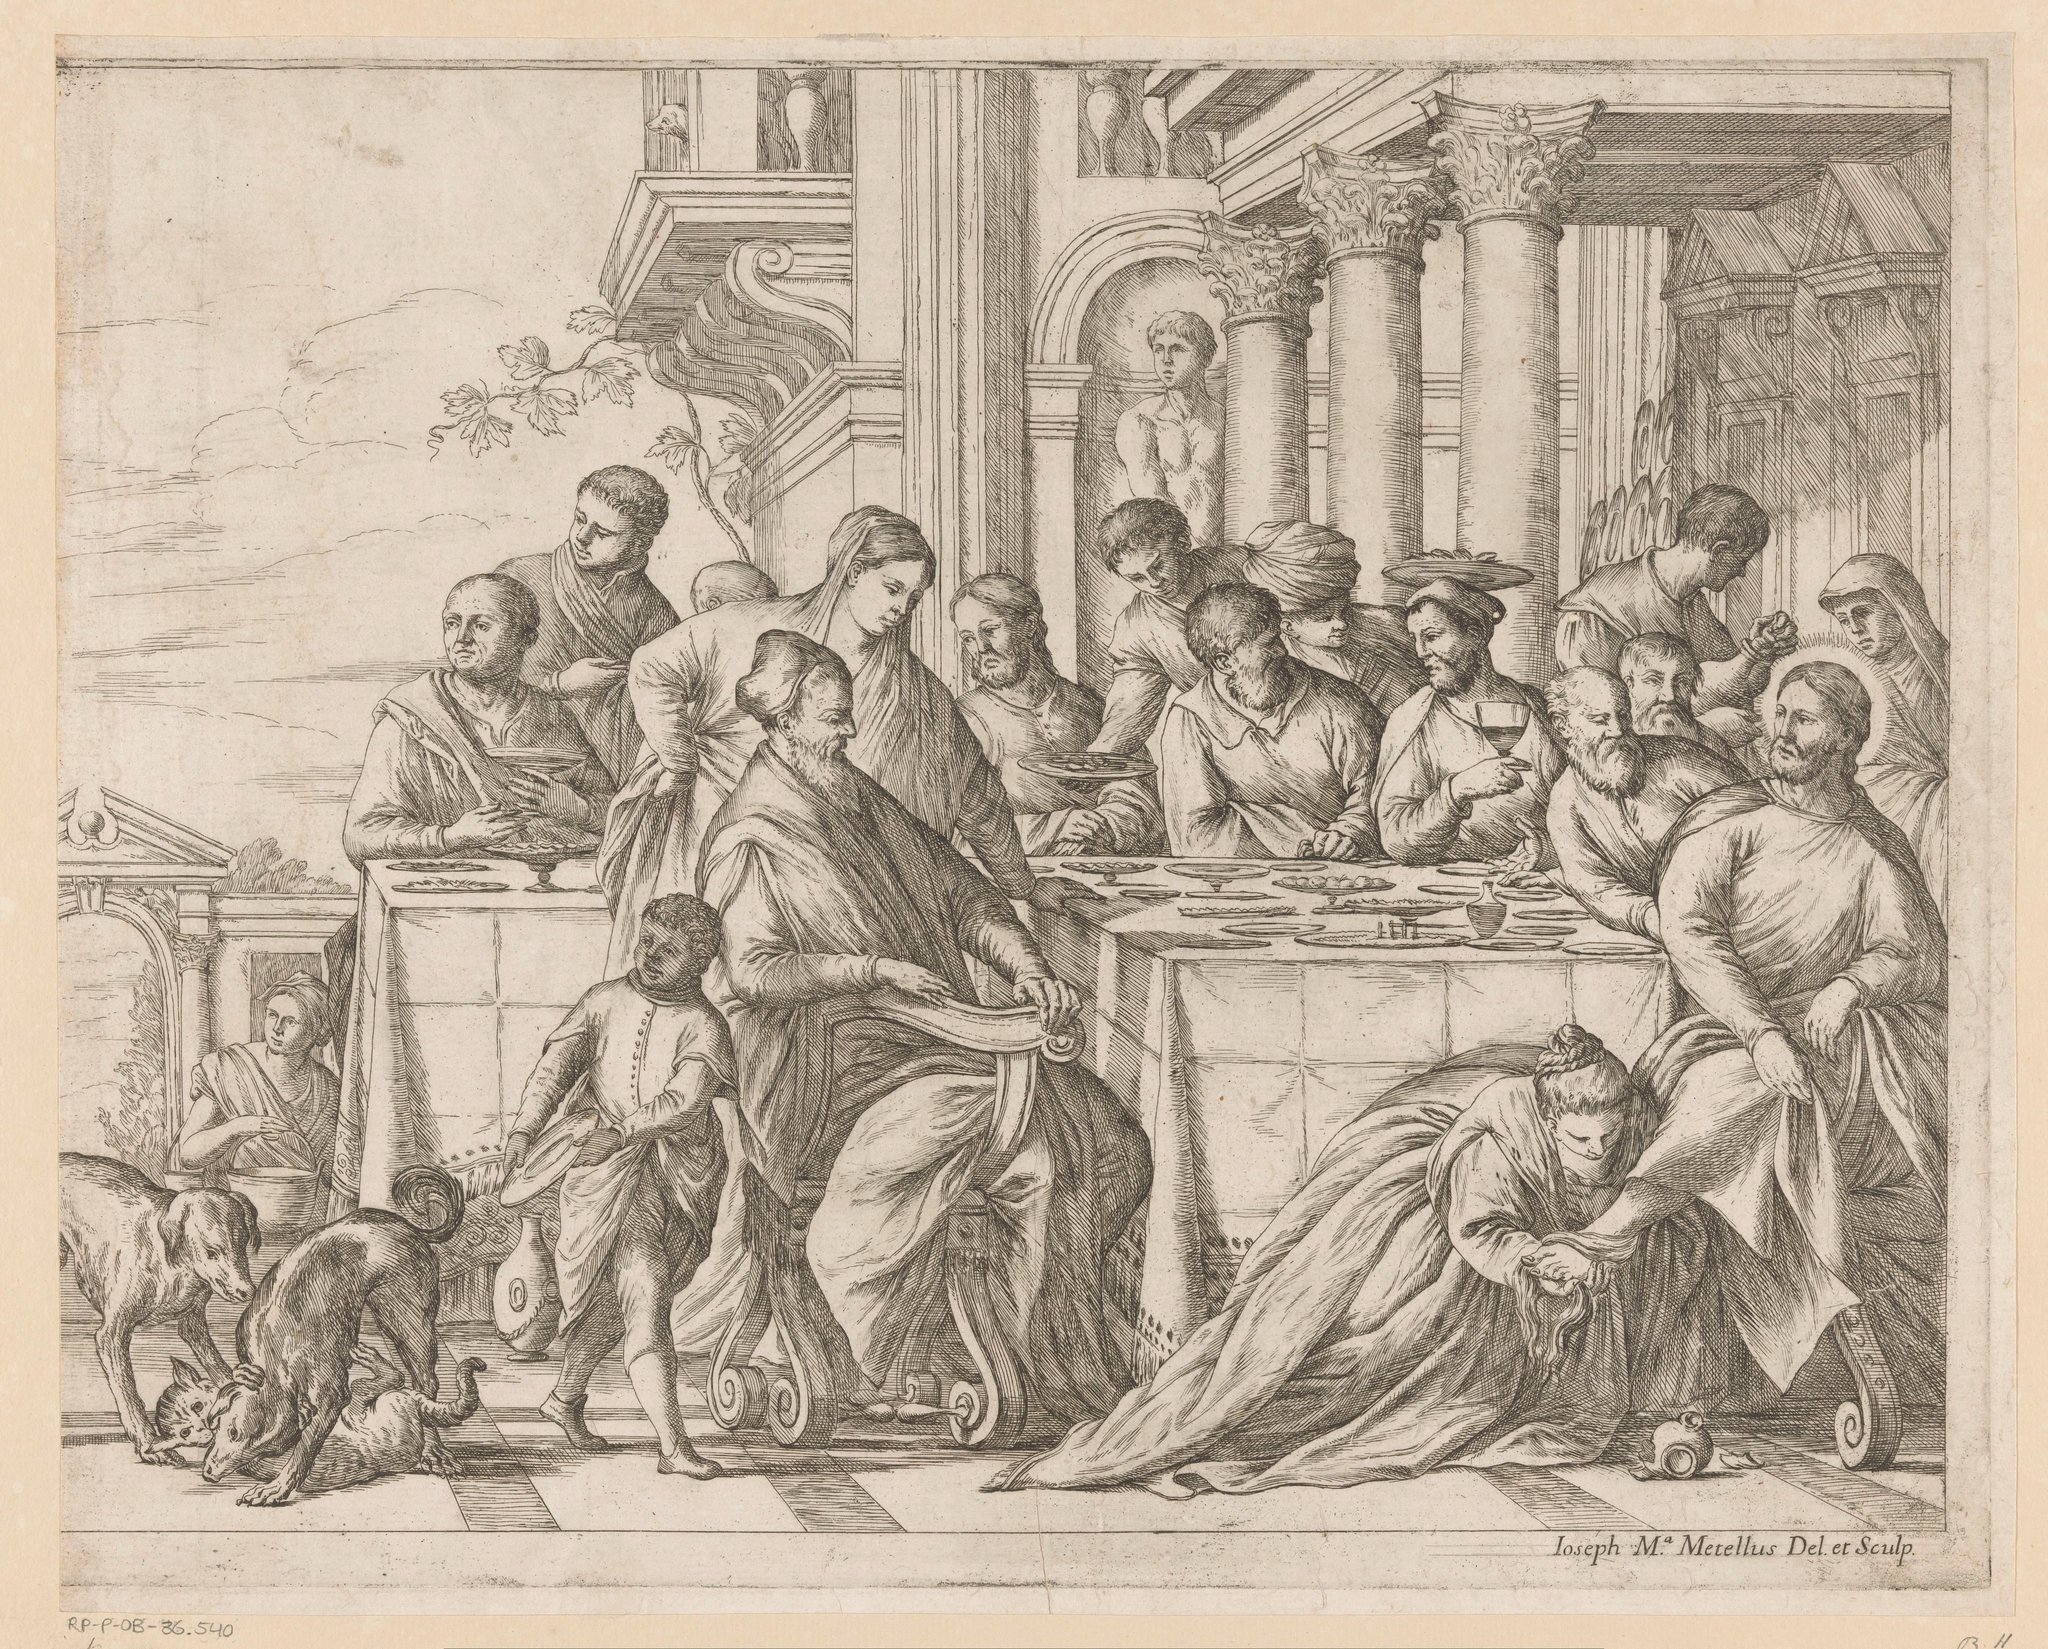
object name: print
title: Christus aan de maaltijd in het huis van Simon de Farizeeër (rechter blad)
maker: giuseppe maria mitelli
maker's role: draughtsman, painter, print maker, publisher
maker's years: 1634-1718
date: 1644-1718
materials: paper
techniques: etching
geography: italy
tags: meal at the house of simon the pharisee (luke 7:36-50)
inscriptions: collector's mark: Lugt 2228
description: Een menigte dinerend rond twee tafels in het huis van Simon de Farizeëer. Rechts Maria Magdalena die de voeten van Christus wast. Links twee honden en een kat.